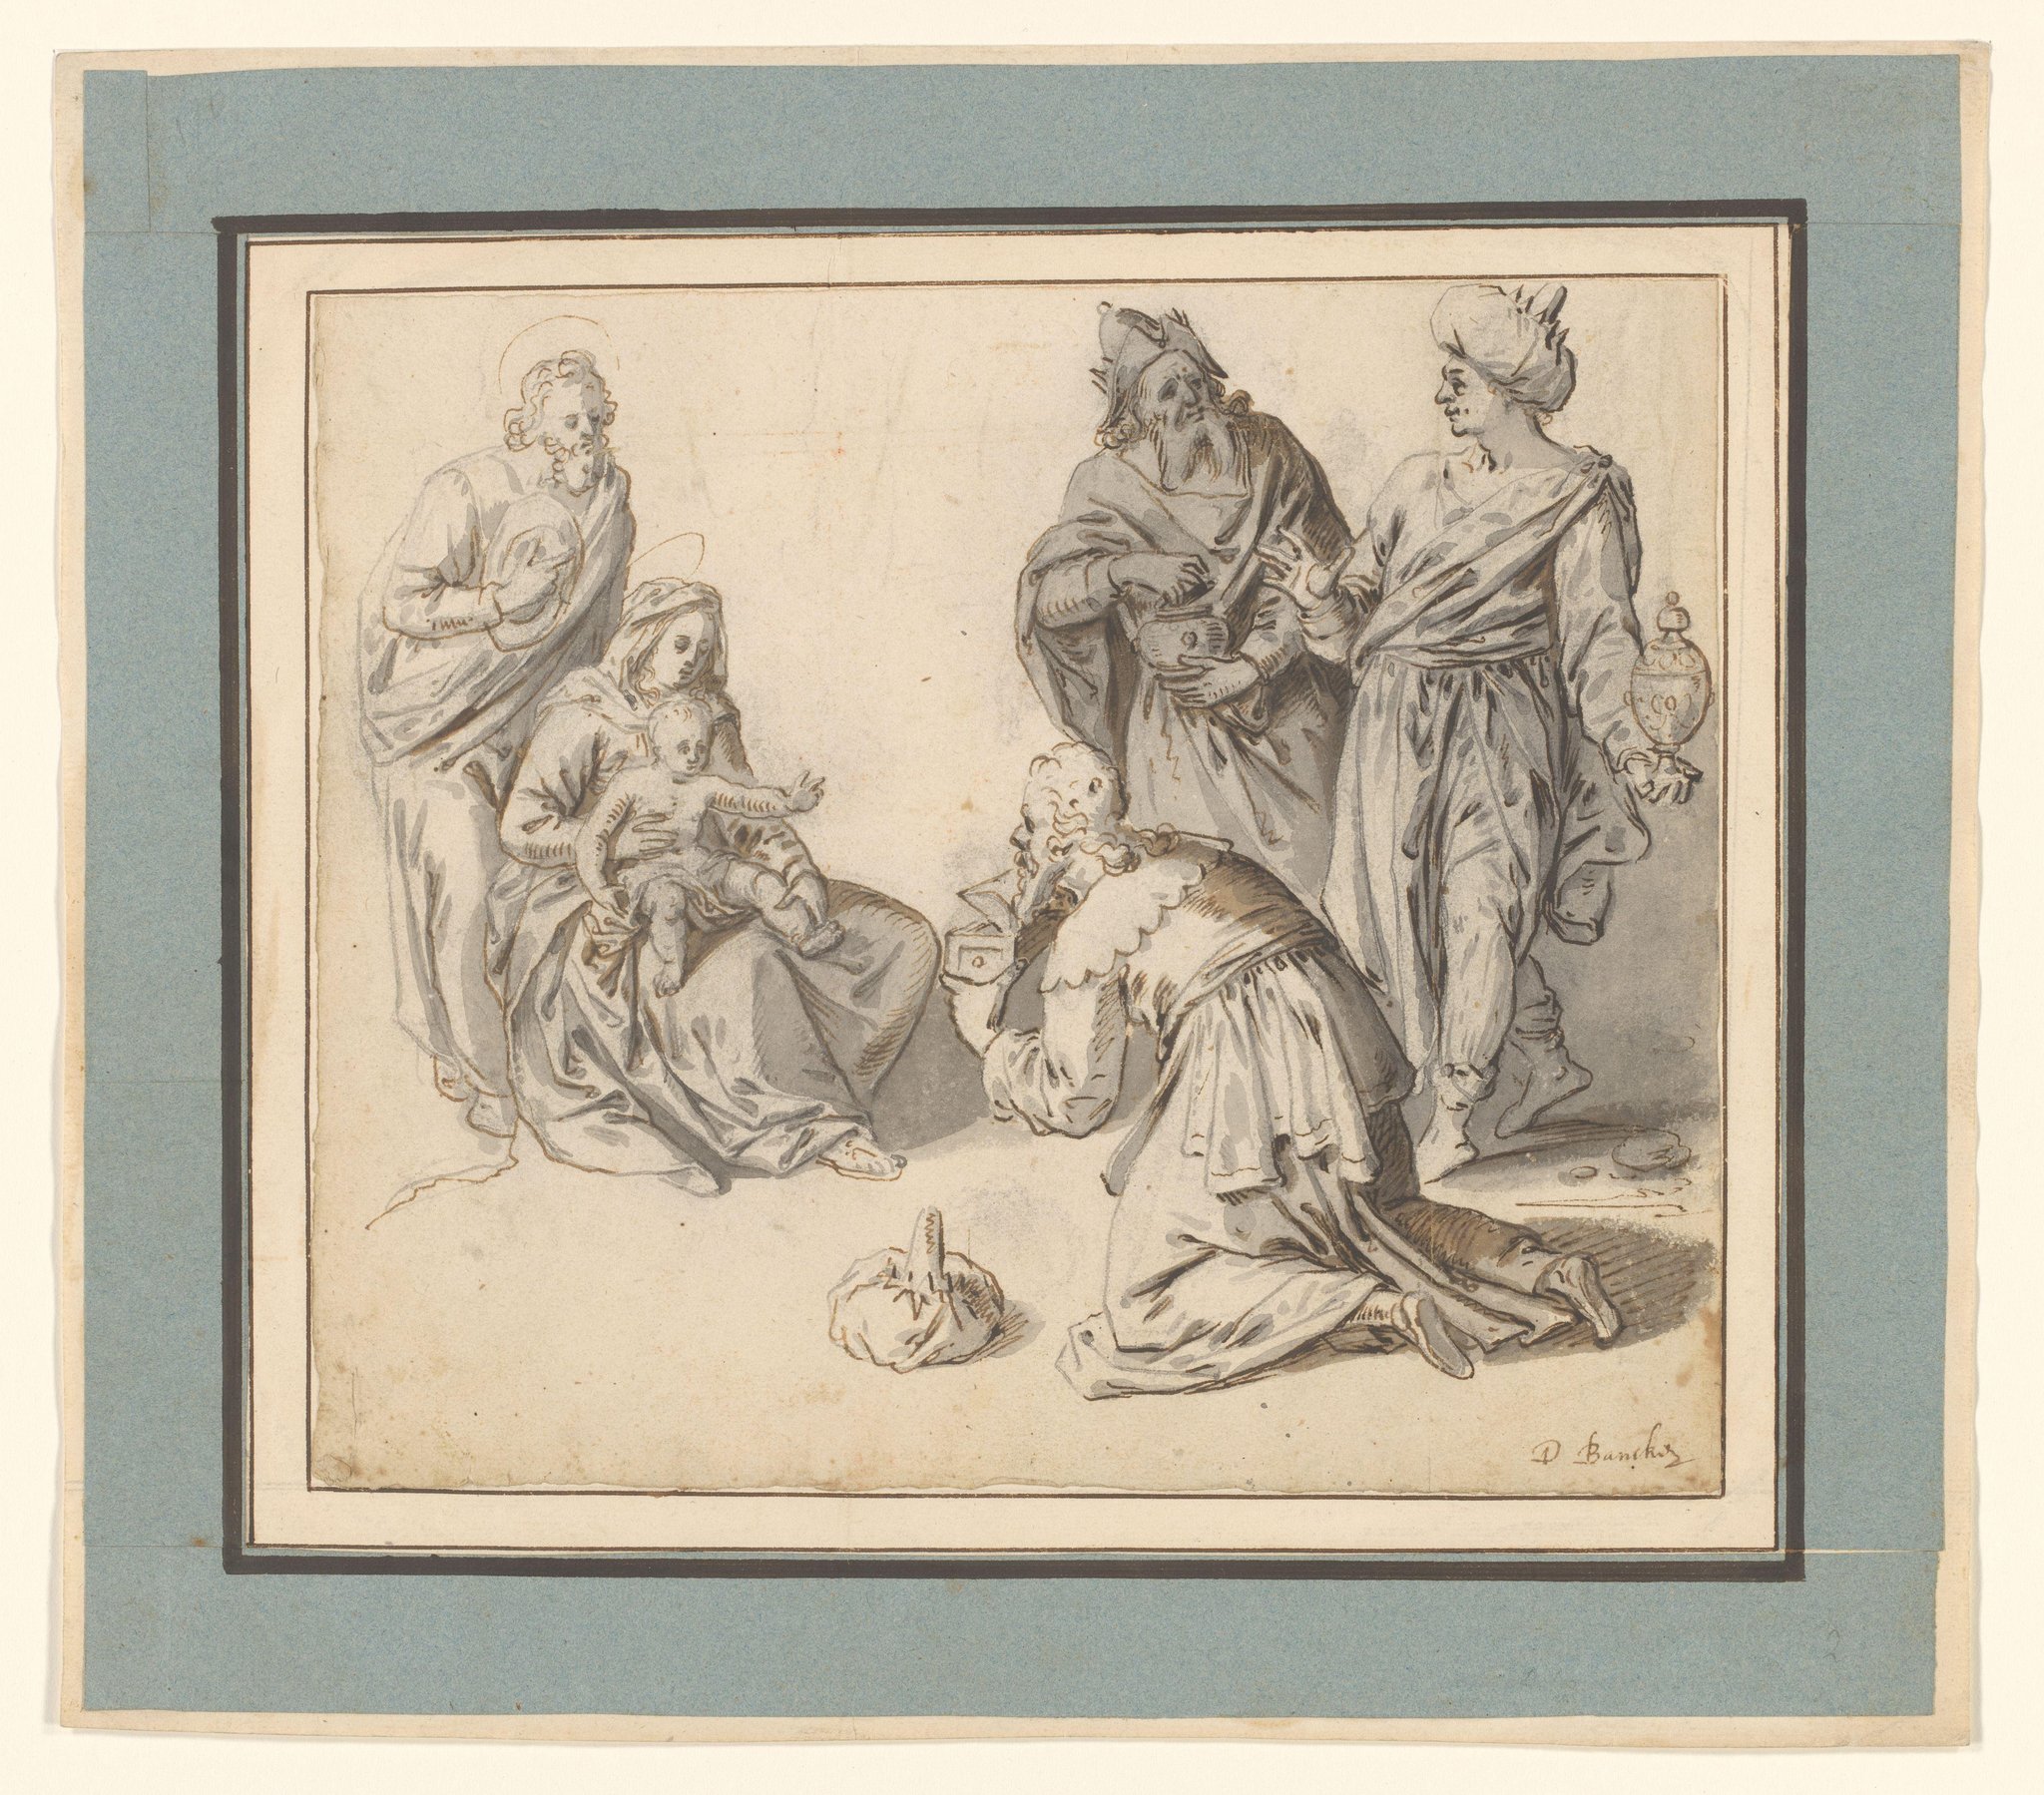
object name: drawing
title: Aanbidding der koningen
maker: quirinus van banken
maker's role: draughtsman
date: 1600-1699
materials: chalk, ink, paper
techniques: brush, pen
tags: adoration of the kings: the wise men present their gifts to the christ-child (gold, frankincense and myrrh)